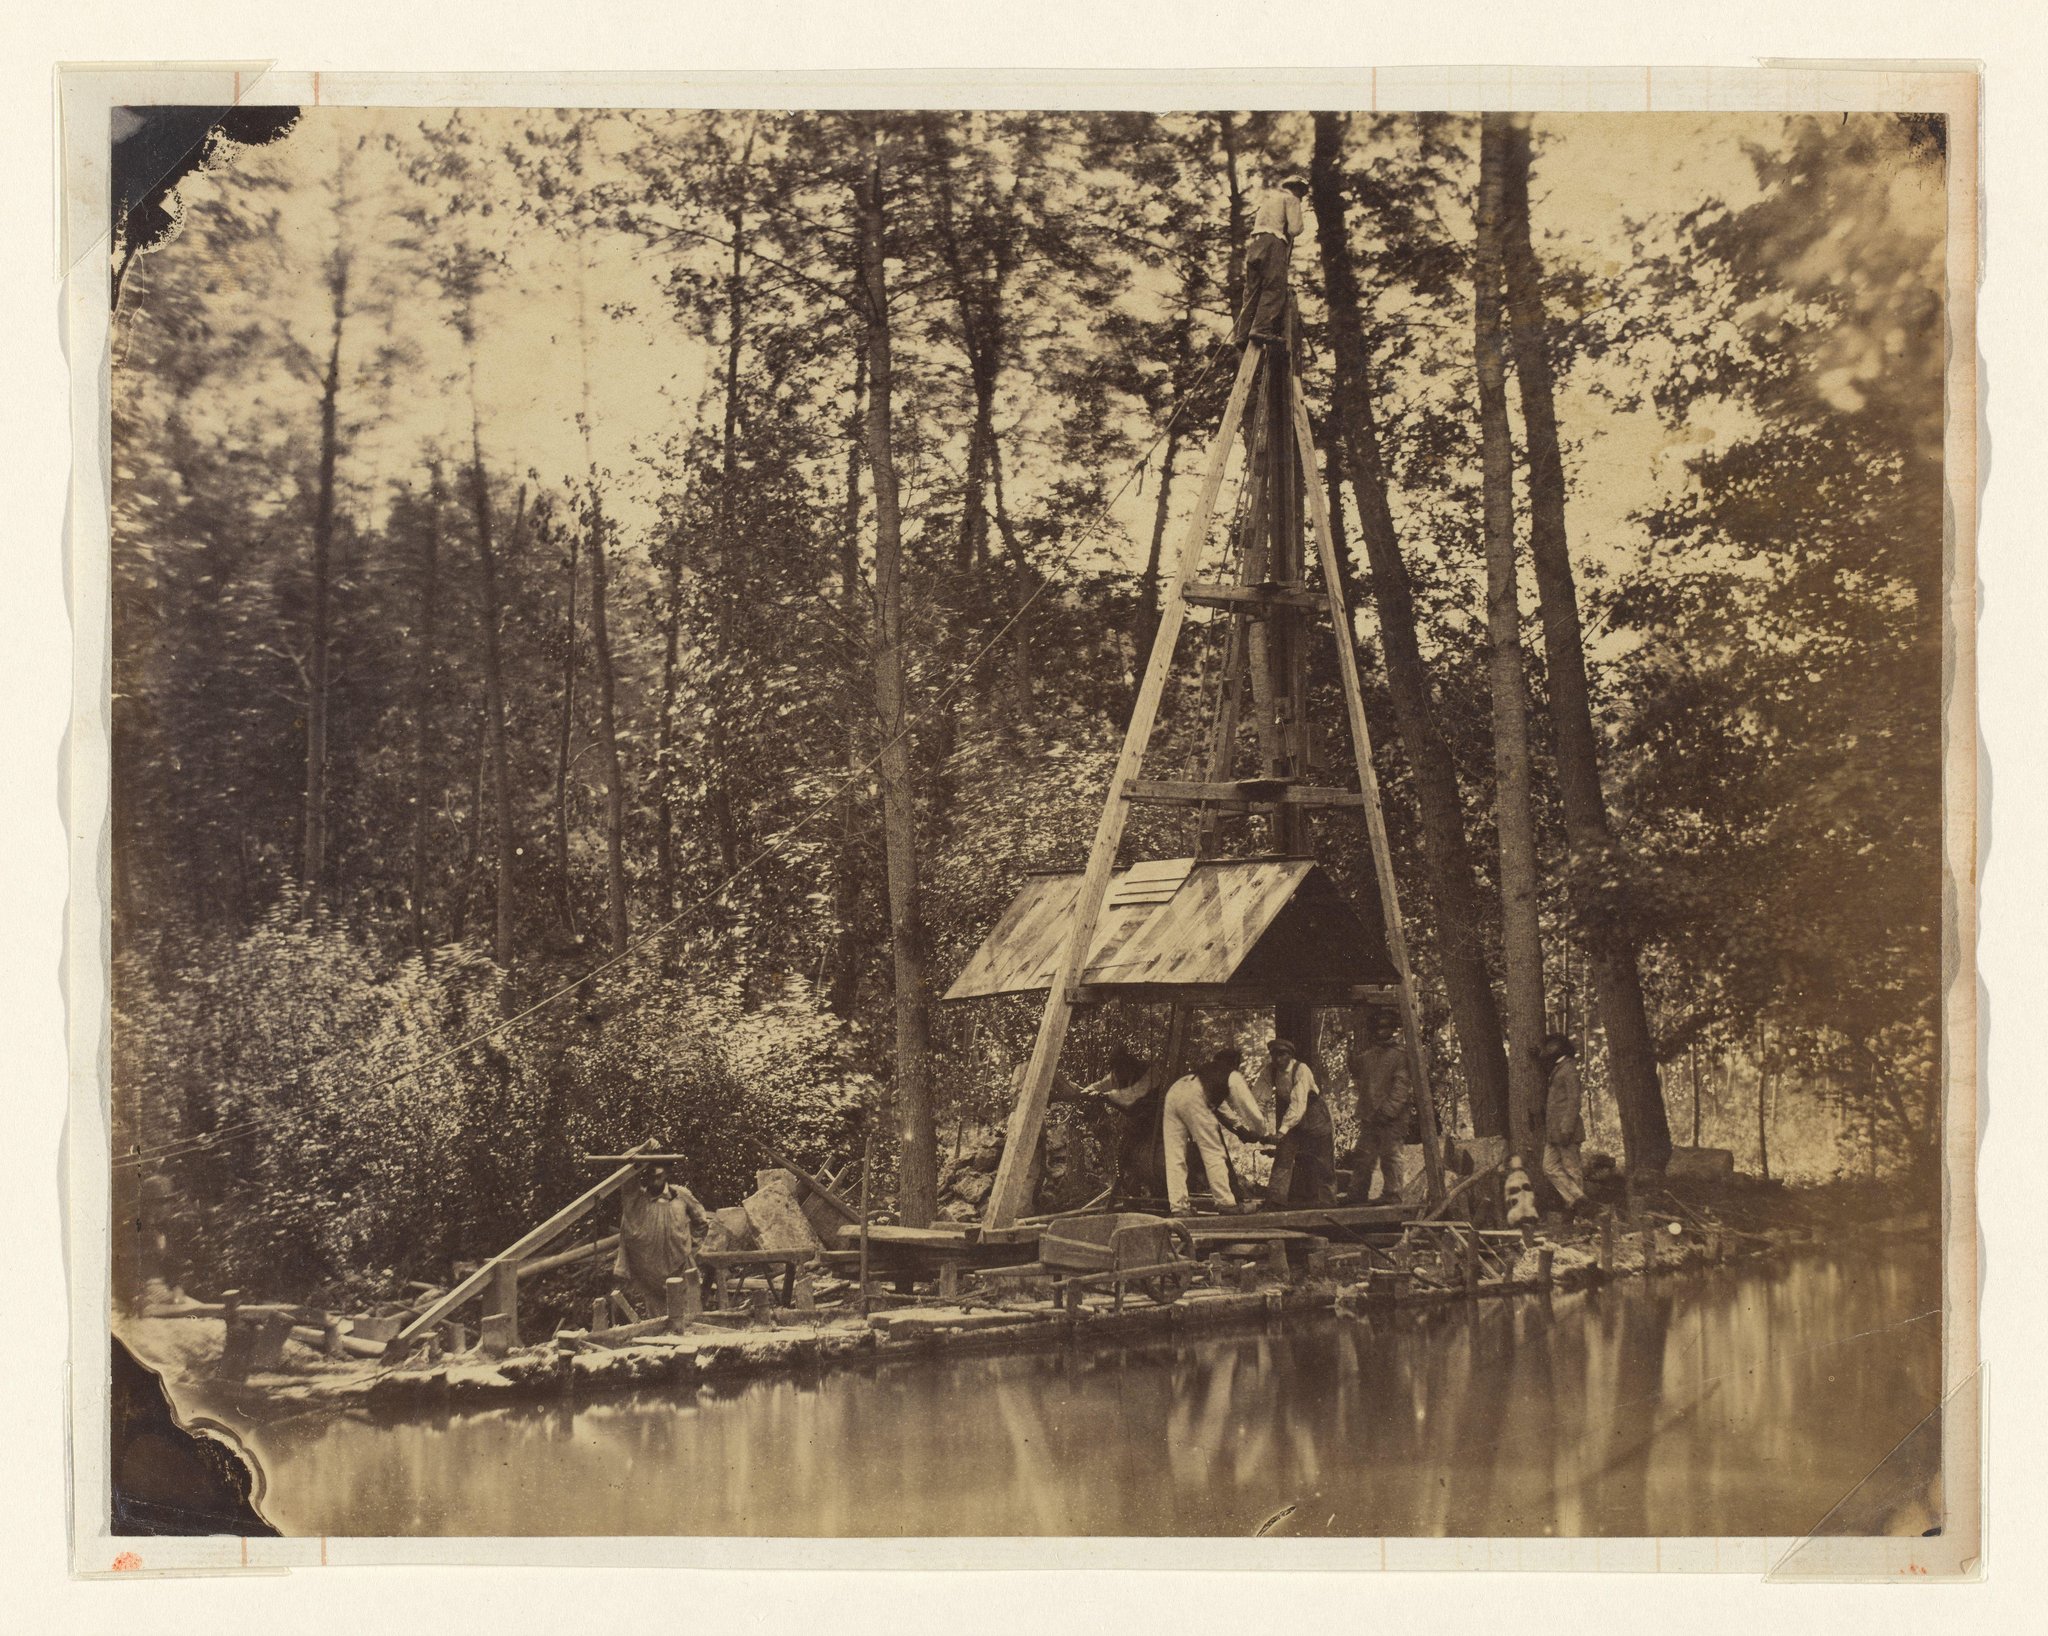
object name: photograph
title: Mannen aan het werk aan de oever van de Mississippi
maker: Anonymous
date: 1880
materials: paper, photographic support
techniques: albumen print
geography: mississippi river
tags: mississippi